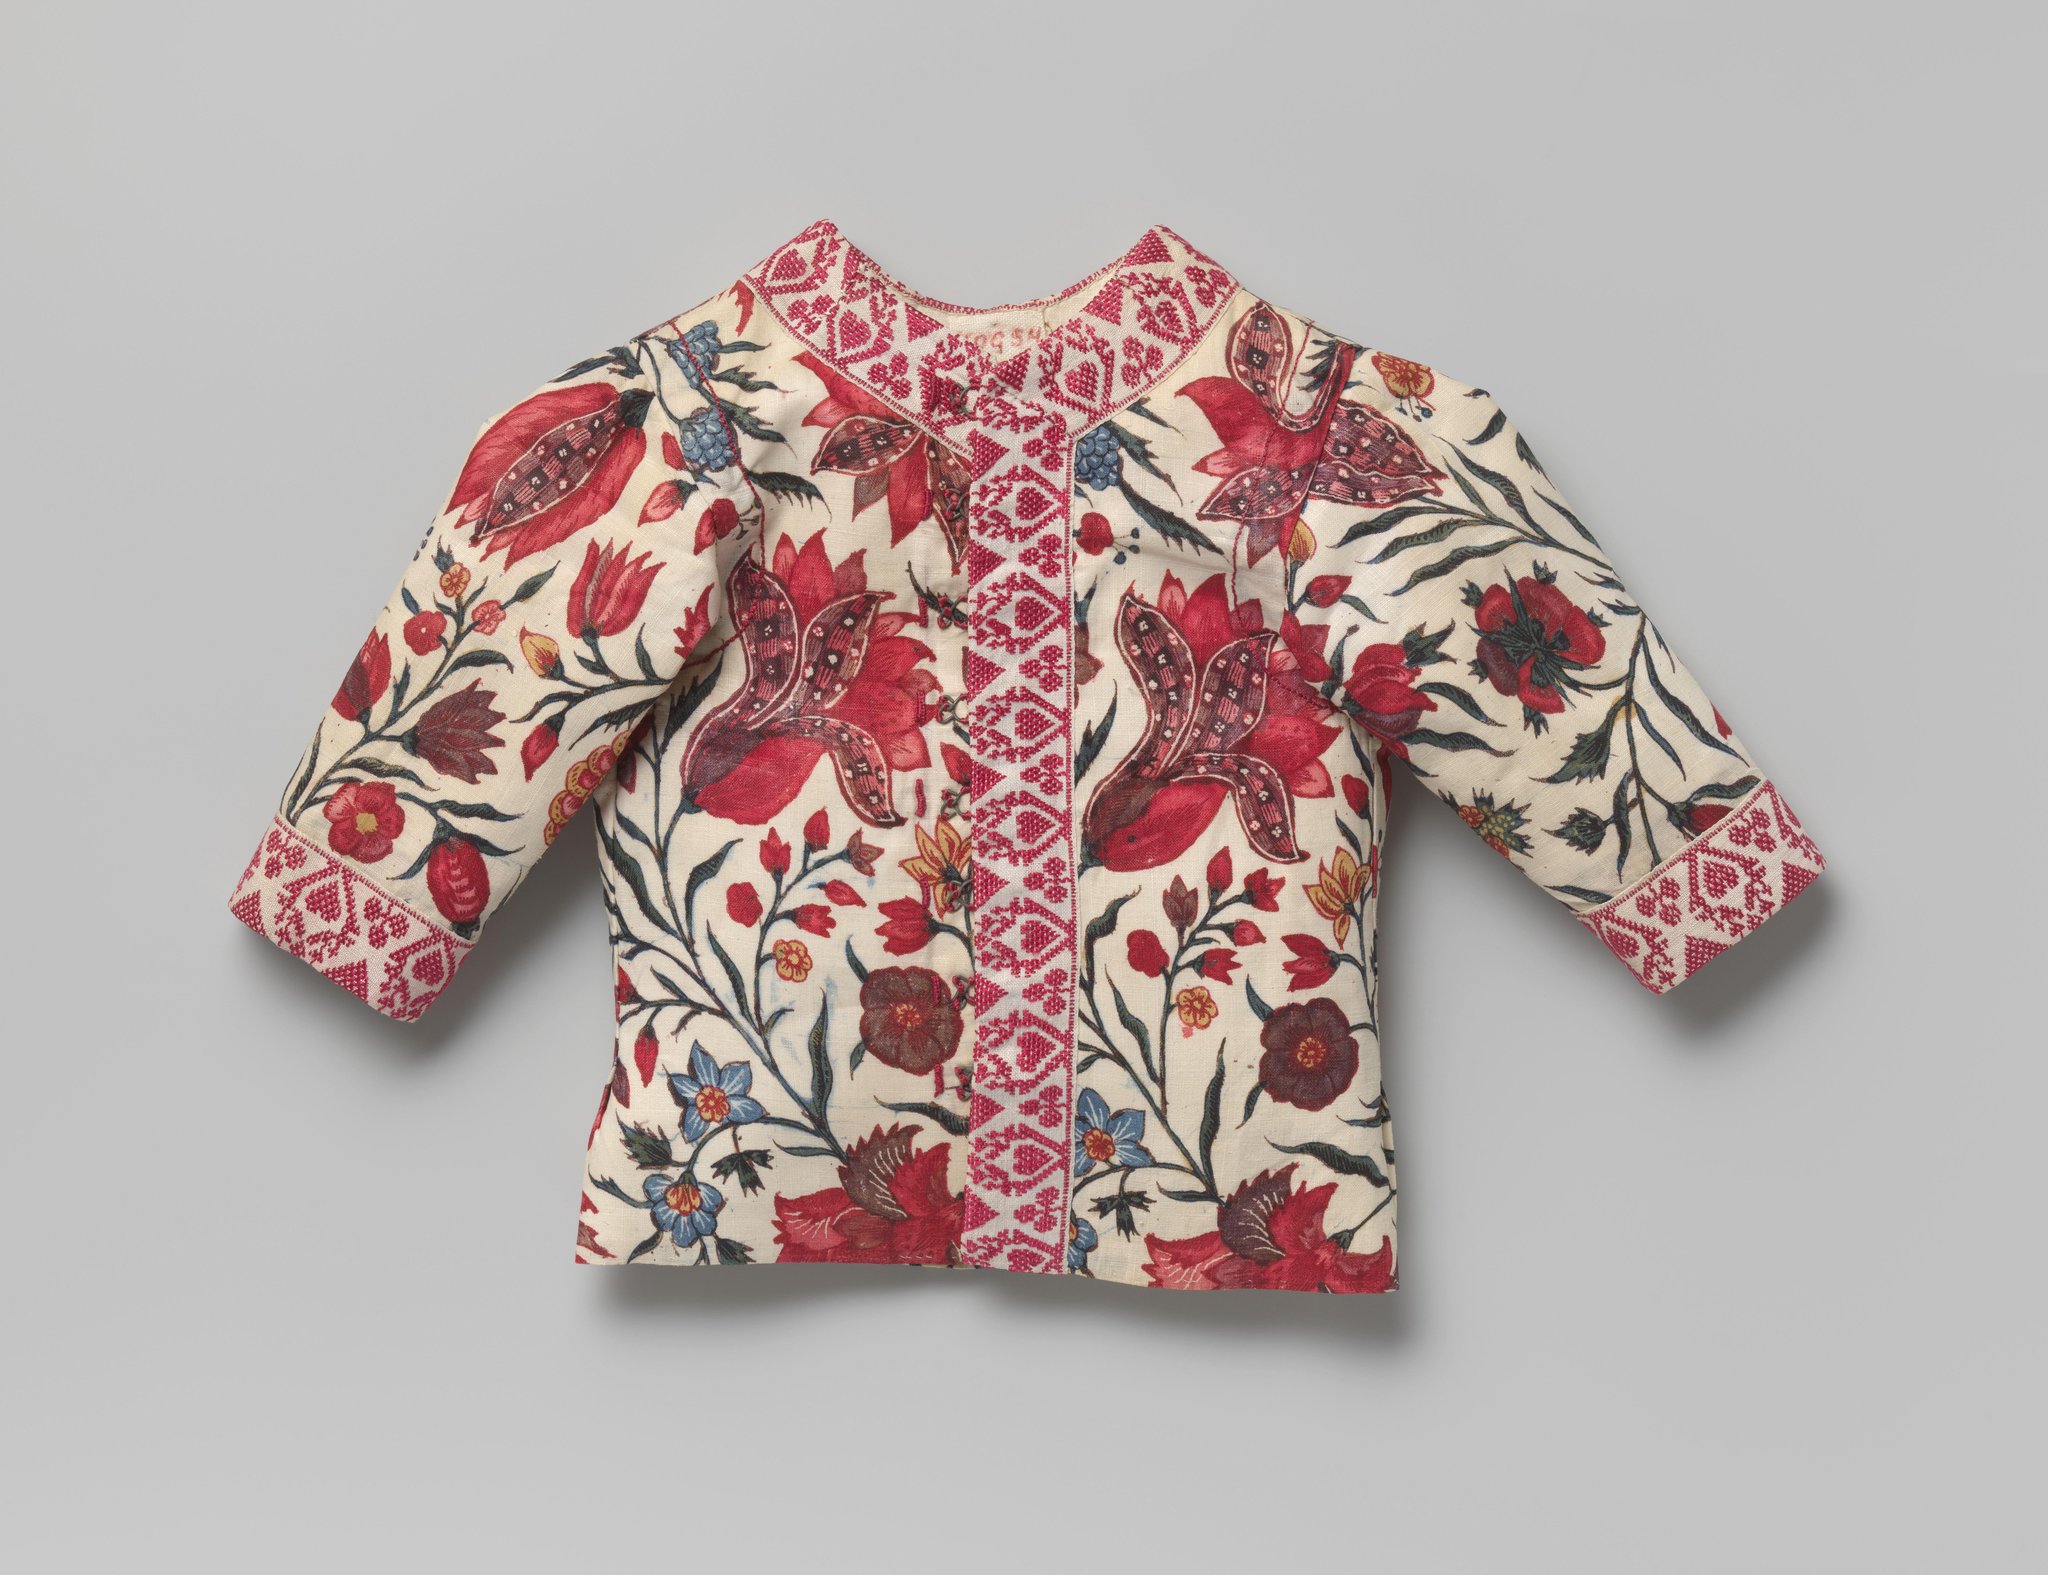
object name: main garment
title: Two Baby’s Jackets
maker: Anonymous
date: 1750-1800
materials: textile, cotton, metal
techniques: embroidered, sewing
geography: netherlands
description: Chintz is eminently suitable for baby clothing because unlike silk and wool it is easy to wash. One jacket is decorated with floral motifs and trimmed at the neck and sleeves with red long-band, while the other one features two birds in addition to flowers. These jackets came from Hindeloopen, where they were called ‘sliepwentke’ or nightgowns.